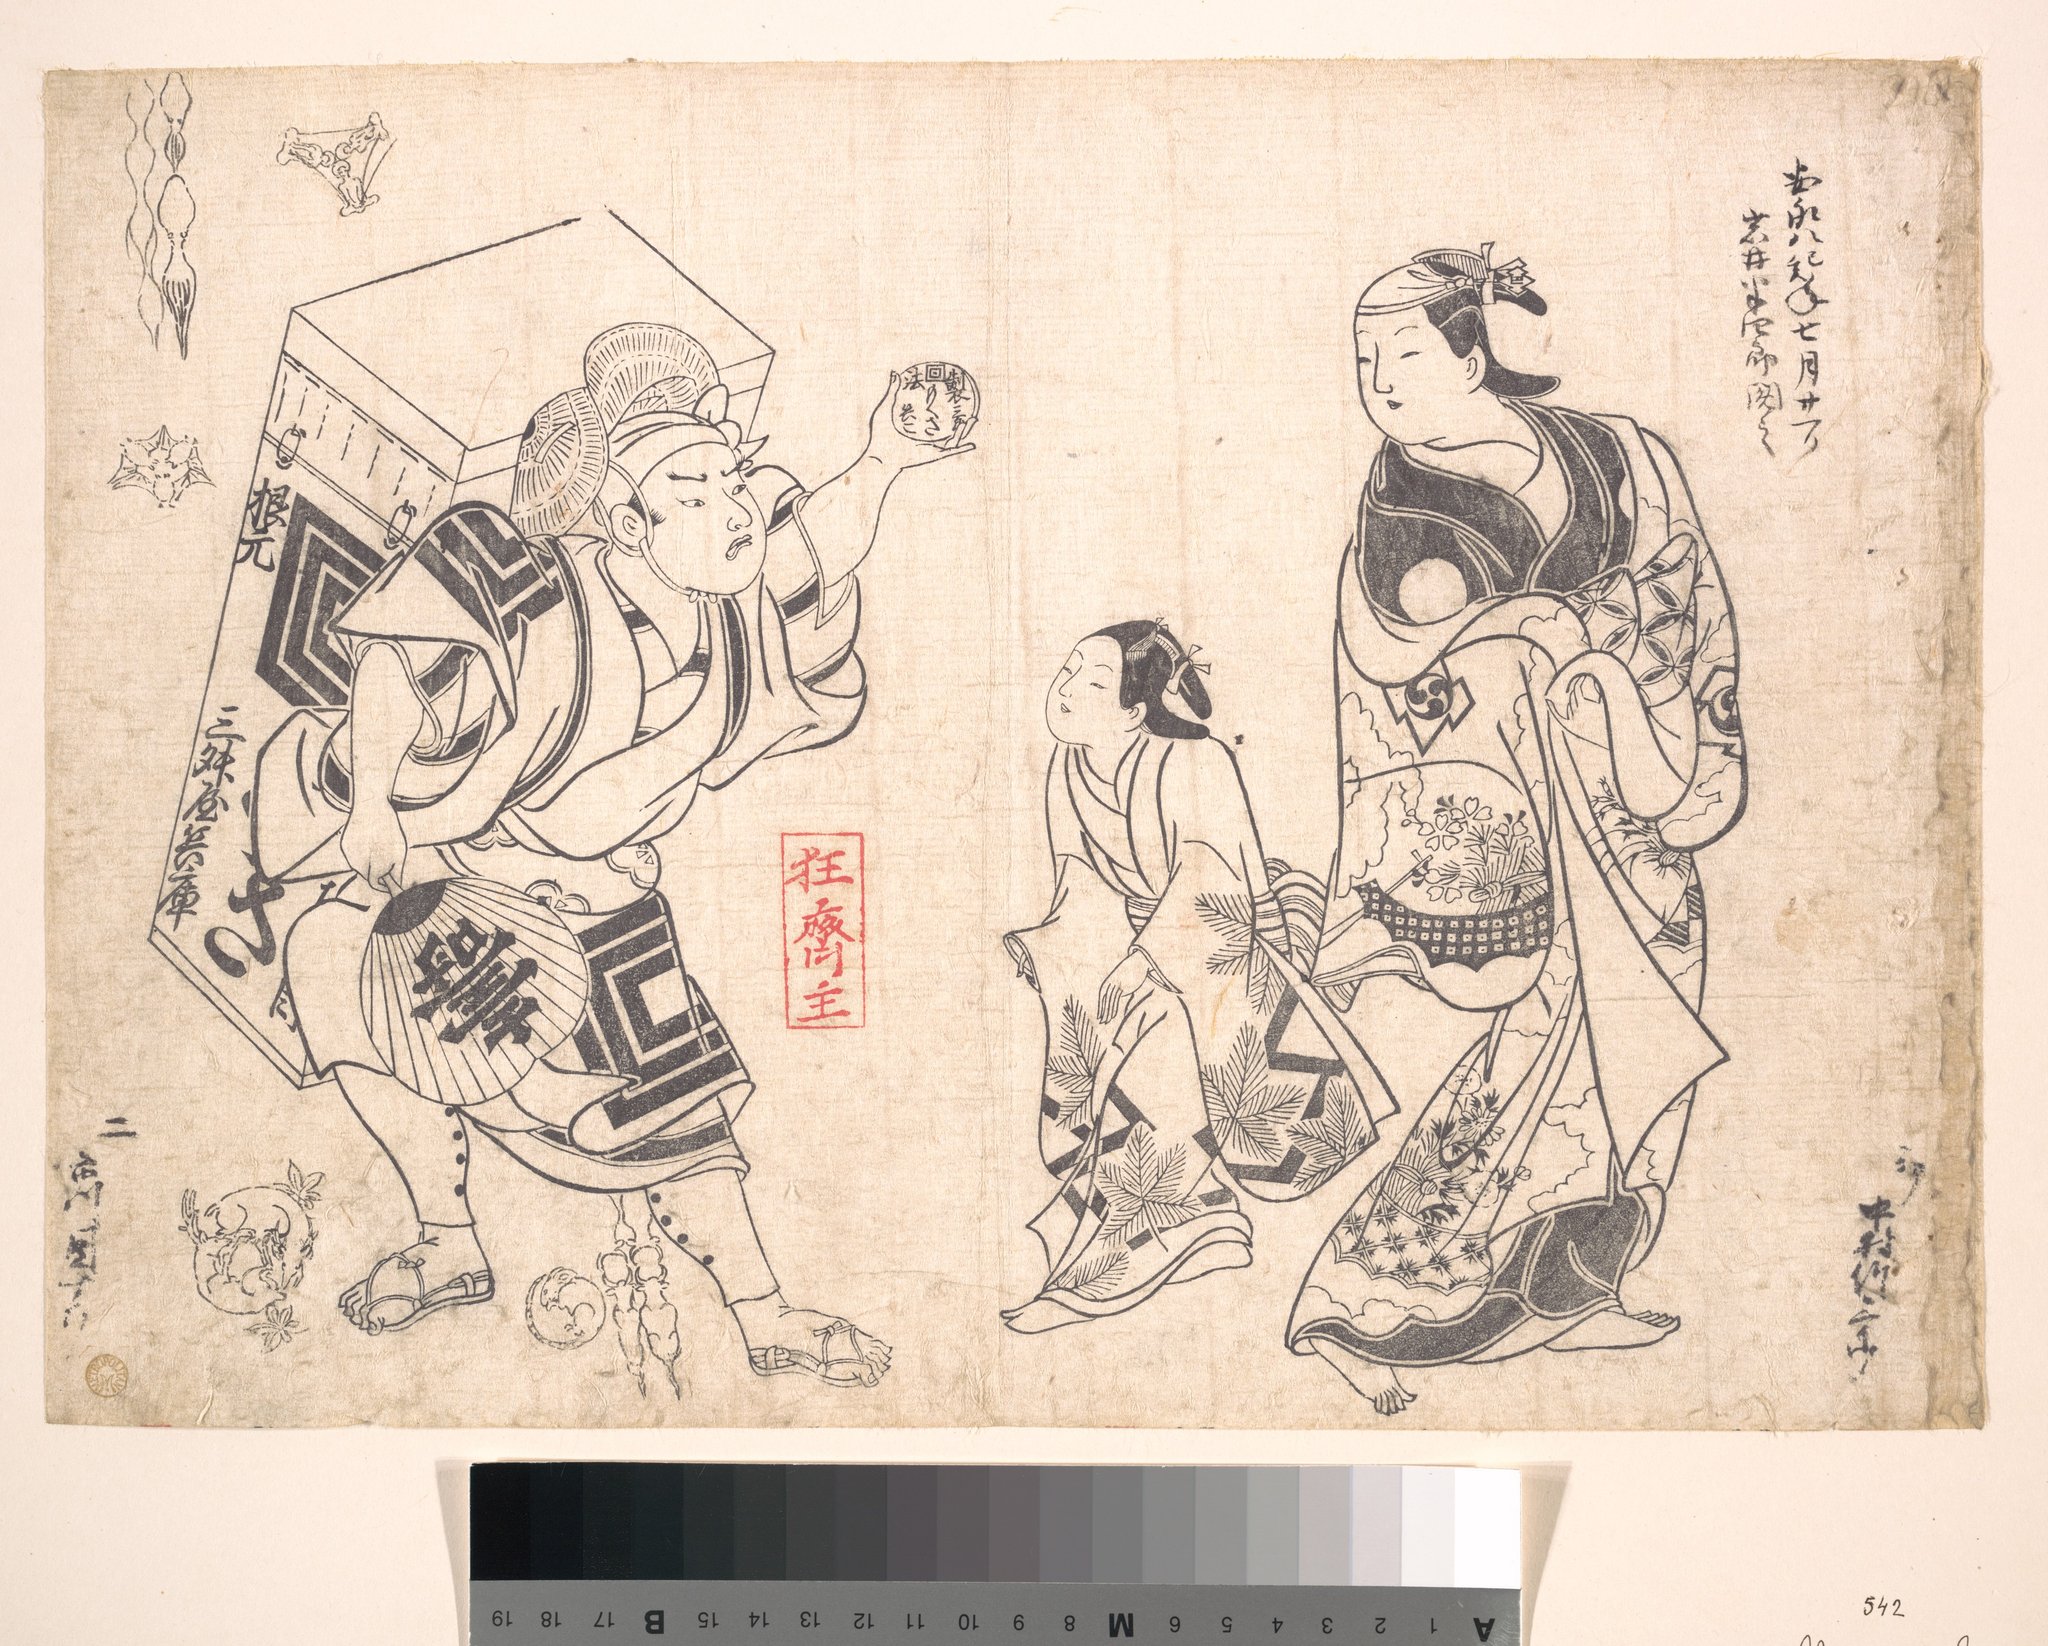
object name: woodblock print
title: The Mogusa-uri Scene from the Drama "Chujo-hime Hibariyama," Performed at Yamamura-za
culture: japanese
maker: okumura masanobu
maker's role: artist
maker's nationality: japanese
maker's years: 1686-1764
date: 1710-1713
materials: ink, paper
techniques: woodblock print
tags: human figures,actors